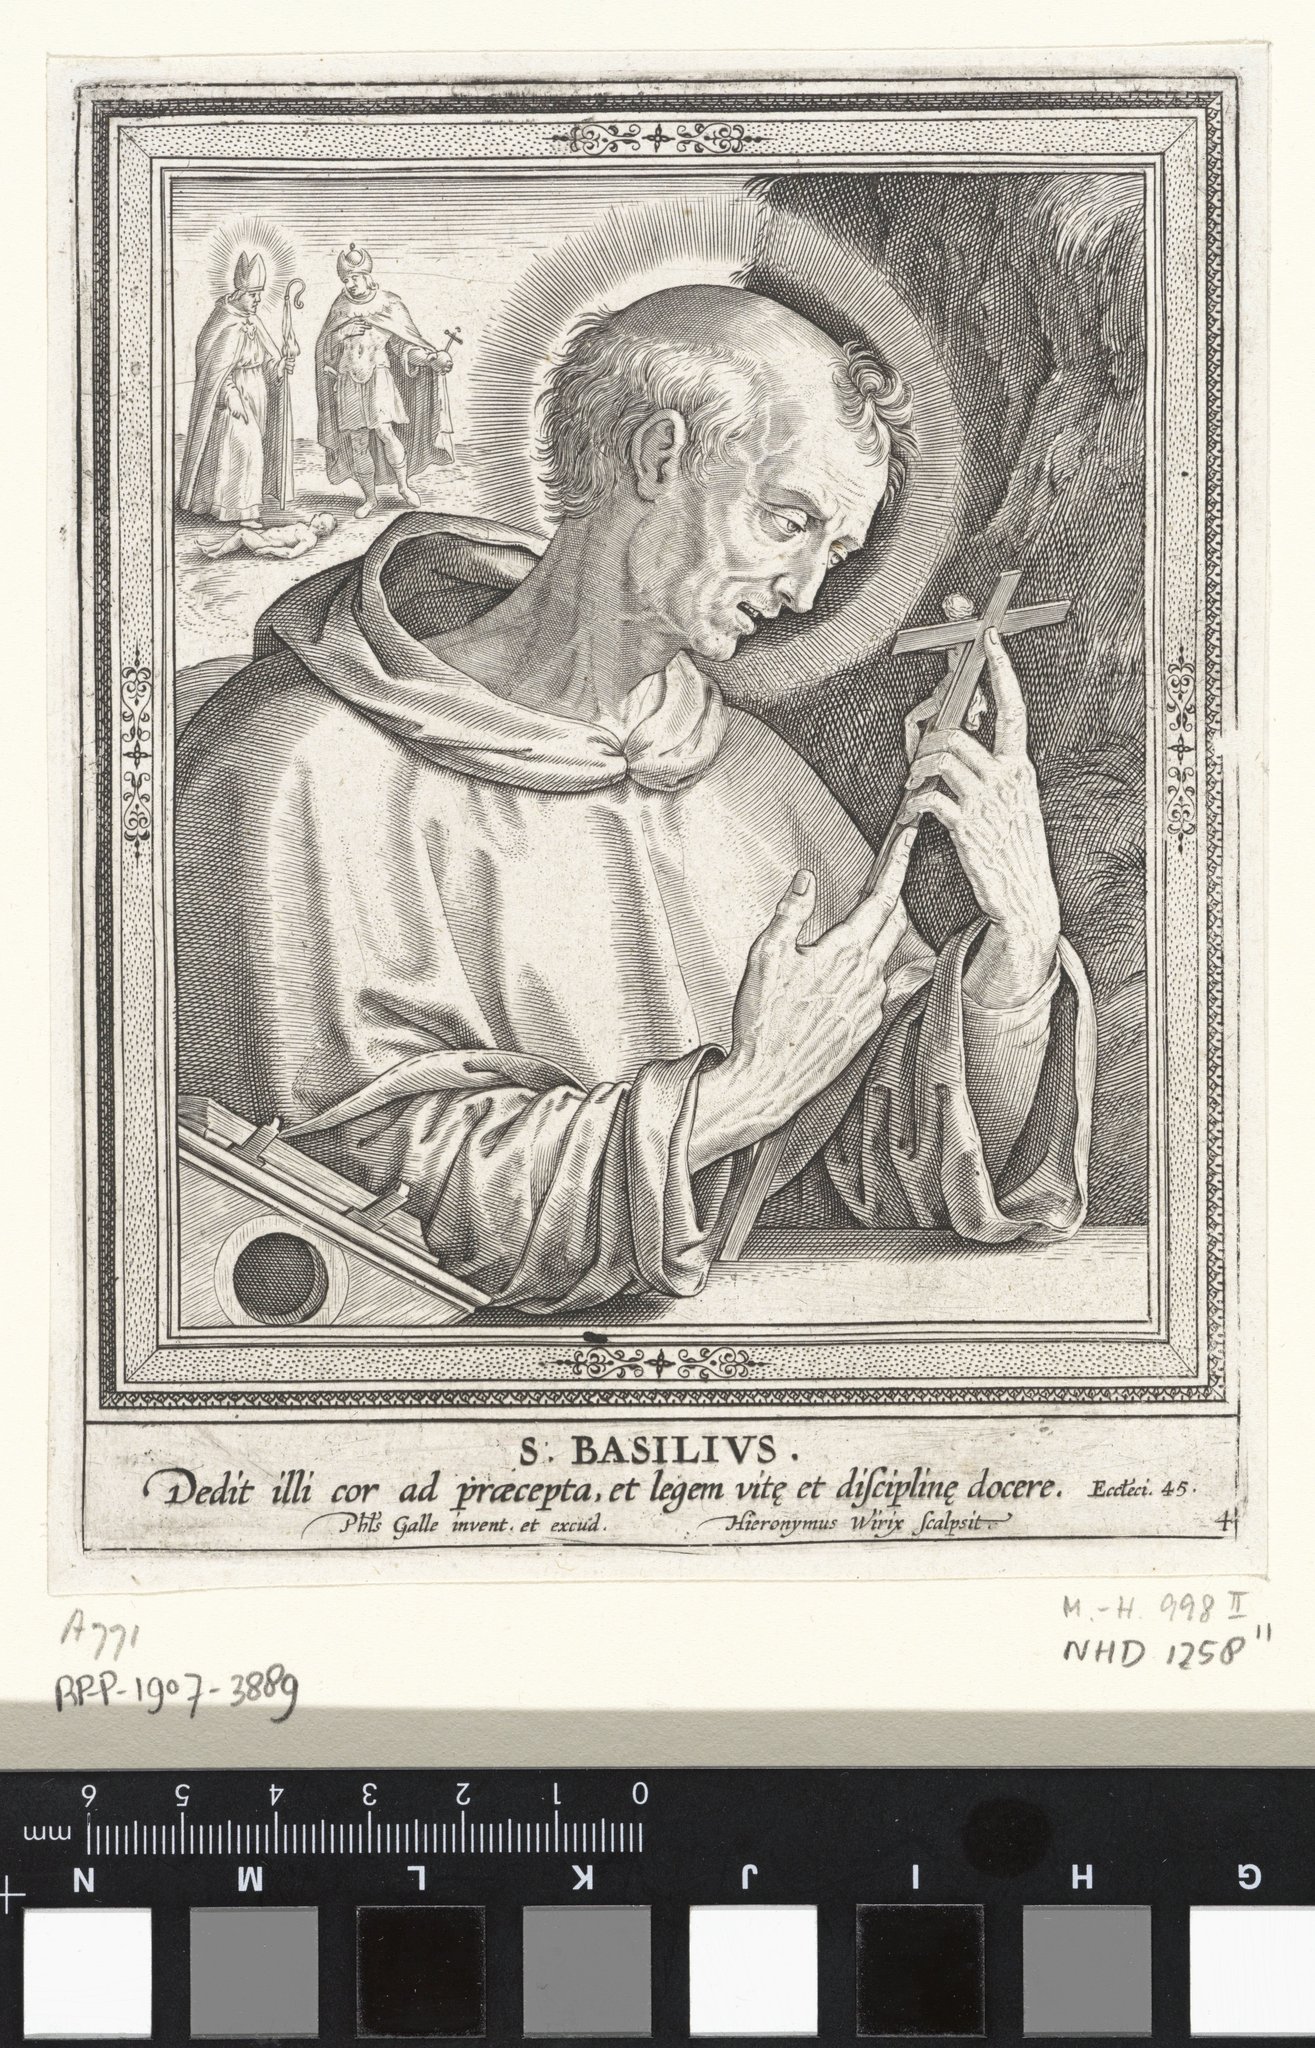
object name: print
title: S. Basilivs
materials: paper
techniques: engraving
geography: antwerp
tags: basil the great (basilius magnus), bishop of caesarea; possible attributes: dove, (column of) fire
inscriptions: collector's mark: Lugt 2542, collector's mark: Lugt 2228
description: De heilige Basilius de Grote, bisschop van Caesarea, stichter van de Cappadocische Vaders, met een crucifix in zijn handen. Links op de achtergrond de heilige Basilius samen met keizer Valens bij diens zieke zoon. In de marge een Bijbelcitaat uit Sir. 45 in het Latijn.